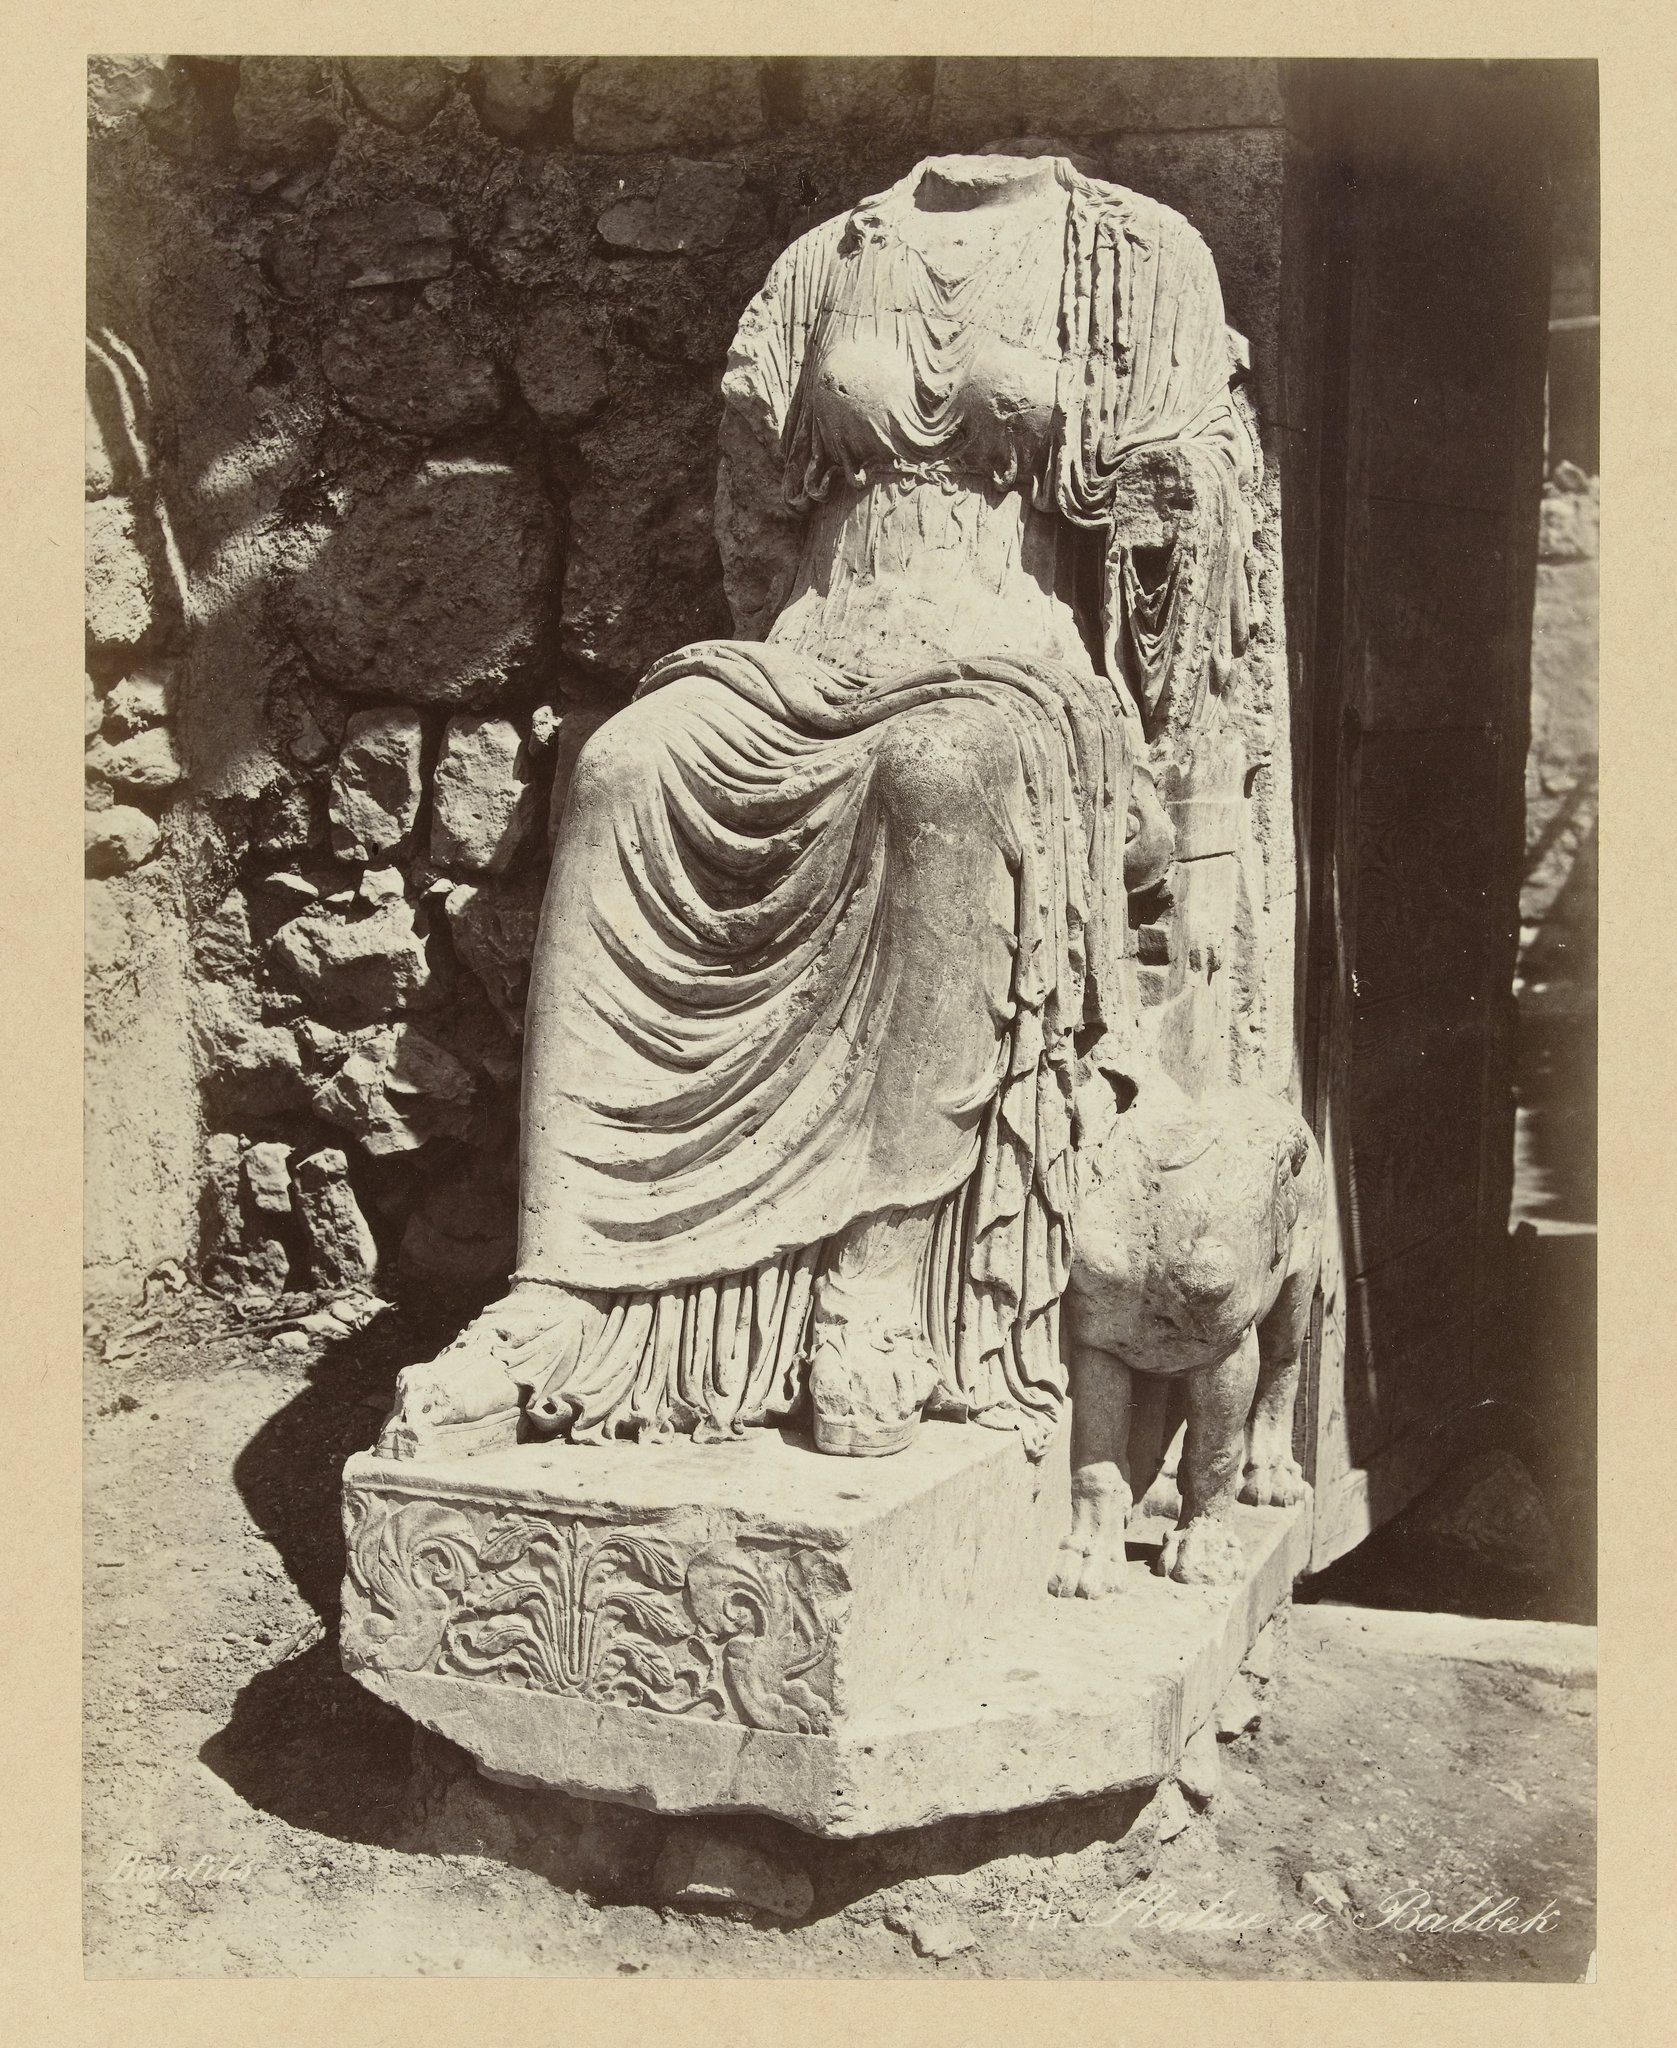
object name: photograph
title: Statue à Balbek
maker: félix bonfils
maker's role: fotograaf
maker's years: 1831-1885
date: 1867-1877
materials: cardboard, paper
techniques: albumen print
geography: baalbek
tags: piece of sculpture, reproduction of a piece of sculpture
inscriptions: title: ‘S 81. Statue (nu te Beyrouth). Baalbec. Syrië.’, stamp: ‘Gemeentelijke bibliotheek/ Rotterdam’, number: ‘474’, check stamp: ‘Bristol/ L.M.’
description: Onderdeel van een groep door fotograaf Richard Polak op reis verzamelde foto’s. Deze foto is samen met andere op zijn reizen verzamelde foto's tentoongesteld bij de Rotterdamsche Kunstkring (1895), Arti en Amicitiae te Amsterdam (1897-1898?) en Societeit 't Collegie te Kampen (datum vooralsnog onbekend).